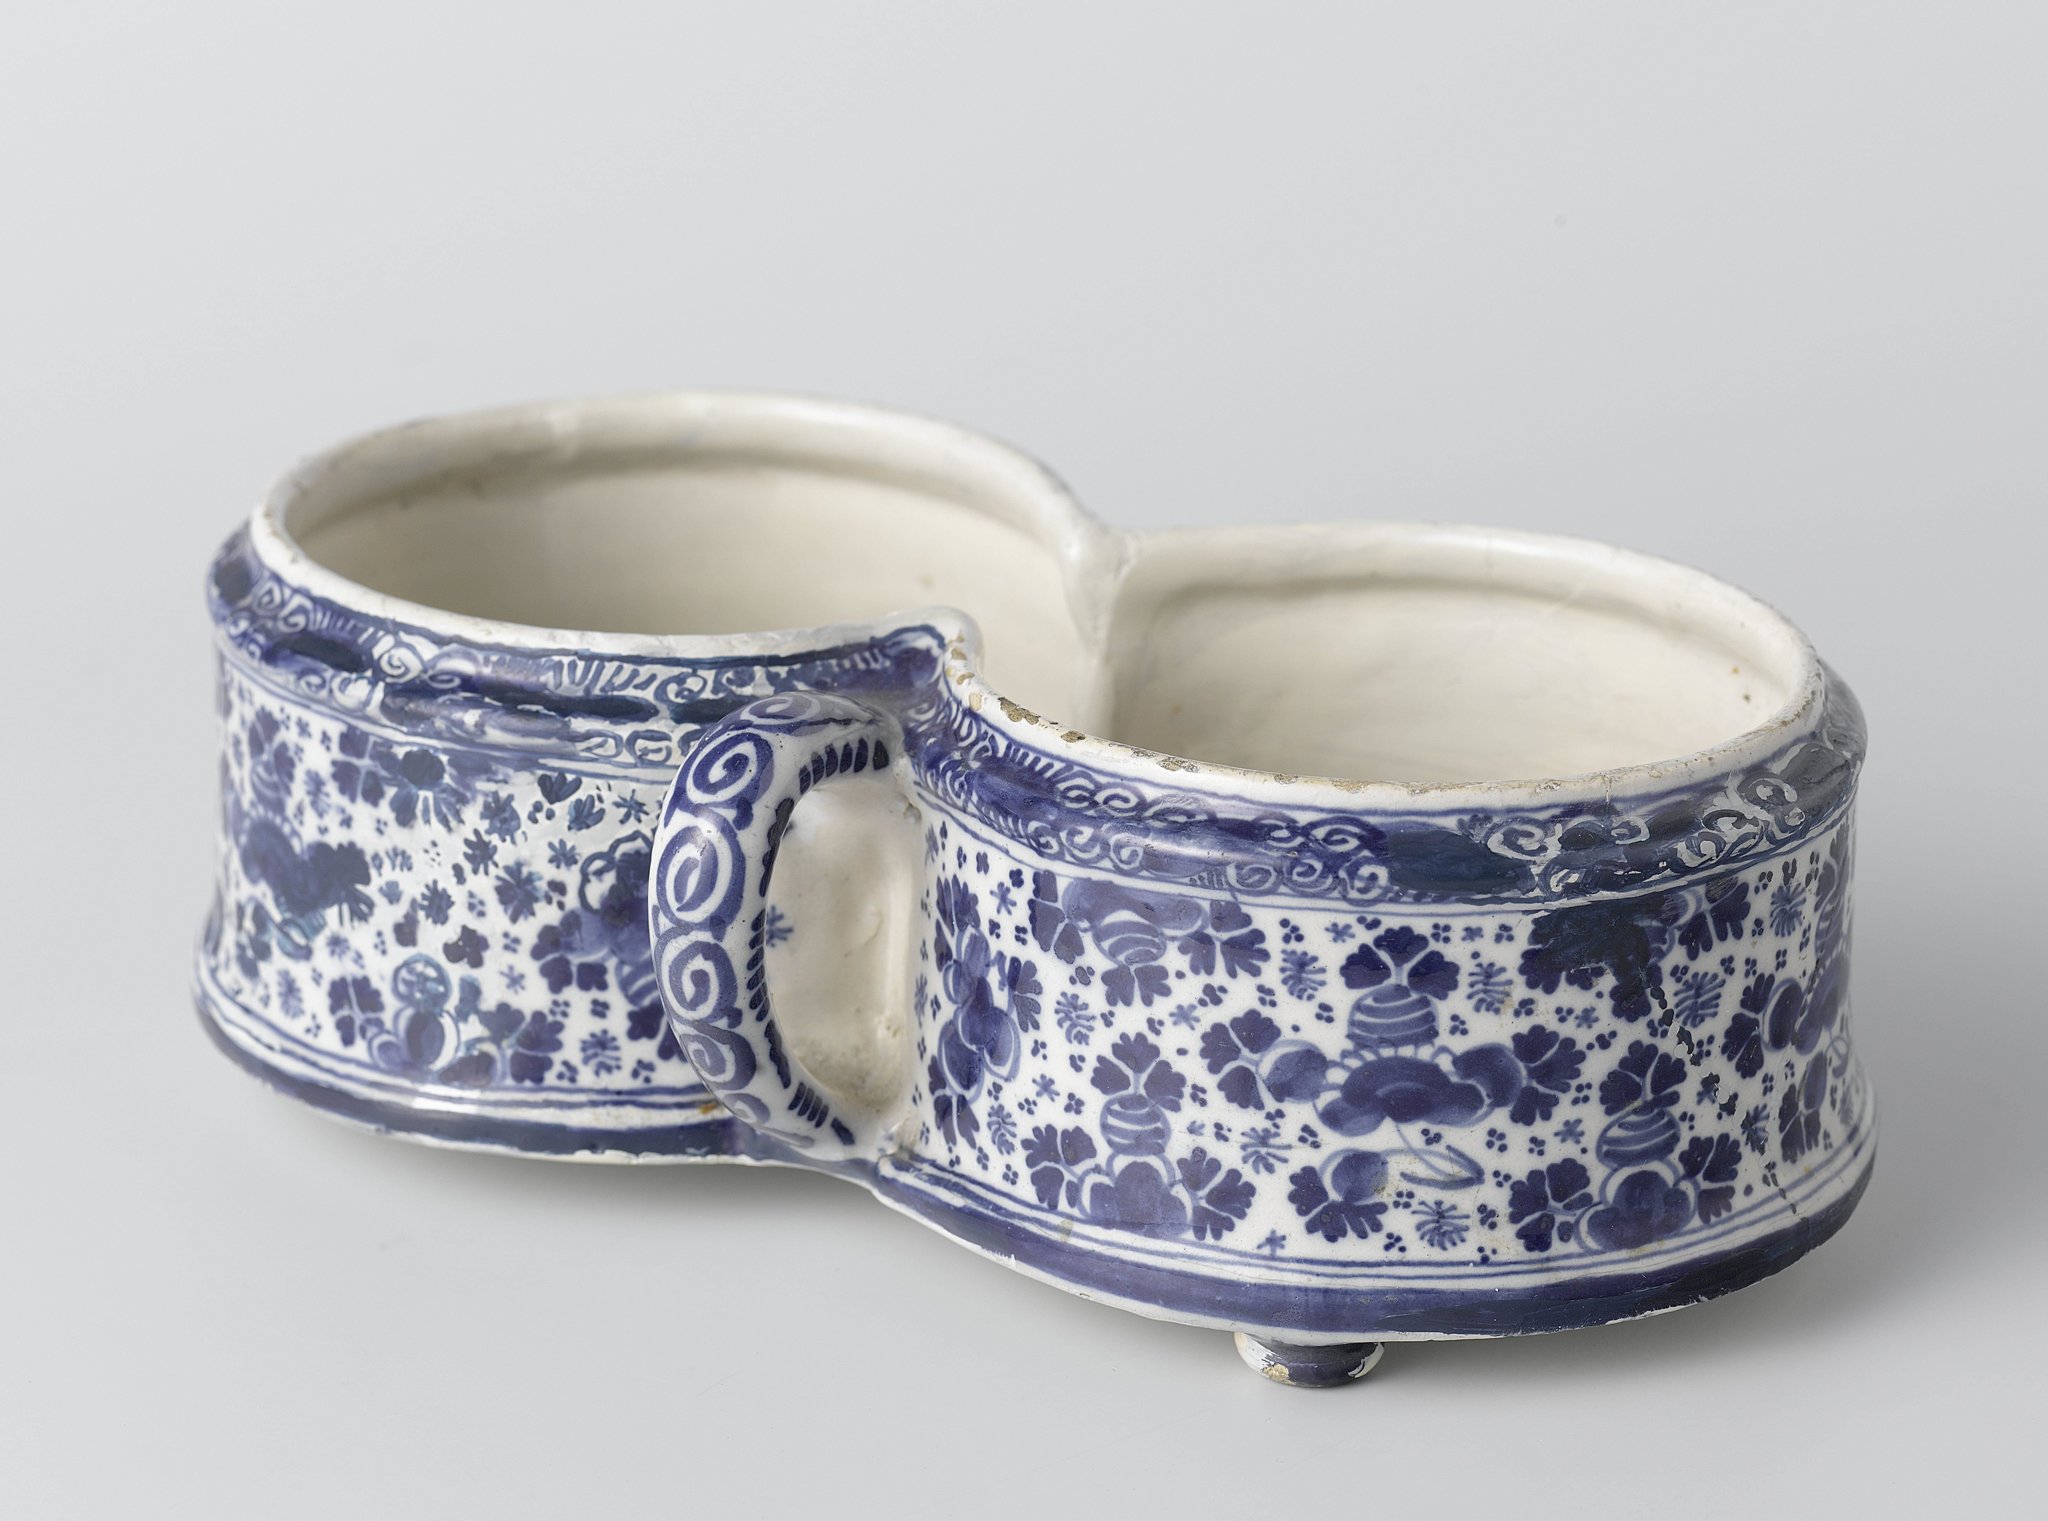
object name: container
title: Bak van olie- en azijnstel, beschilderd in blauw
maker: Anonymous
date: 1710-1750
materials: faience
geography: delft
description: Bak van olie- en azijnstel van faience. Blauw beschilderd. Zonder de glazen flesjes.